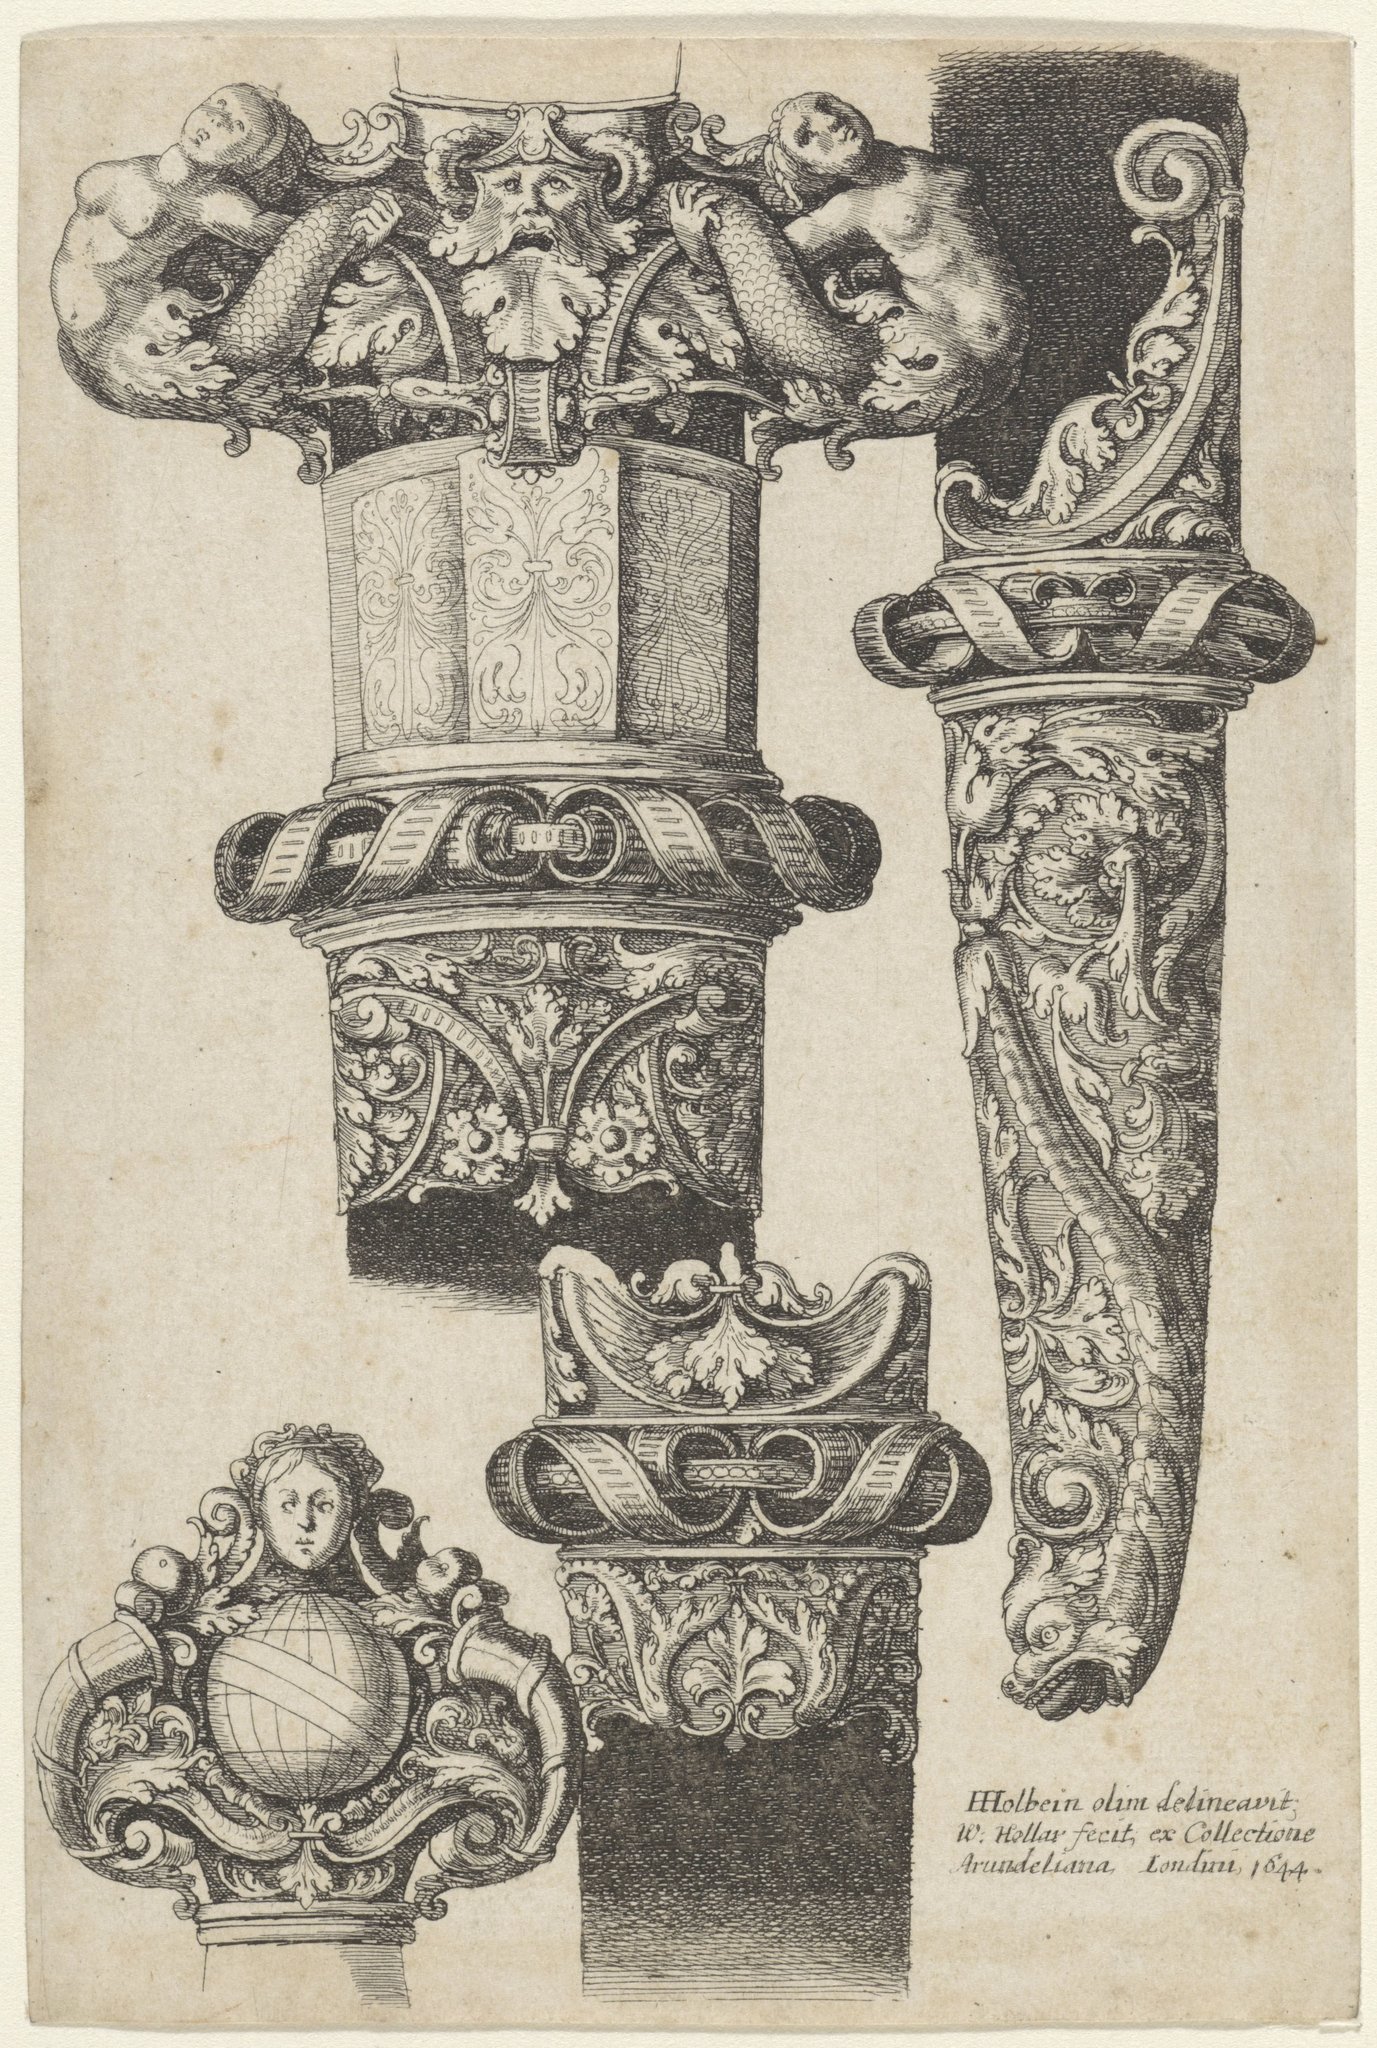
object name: print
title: Ornamenteel ontwerp voor een dolk en schede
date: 1644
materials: paper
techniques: etching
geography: antwerp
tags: hacking and thrusting weapons: dagger, scabbard, sheath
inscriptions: collector's mark: Lugt 2228